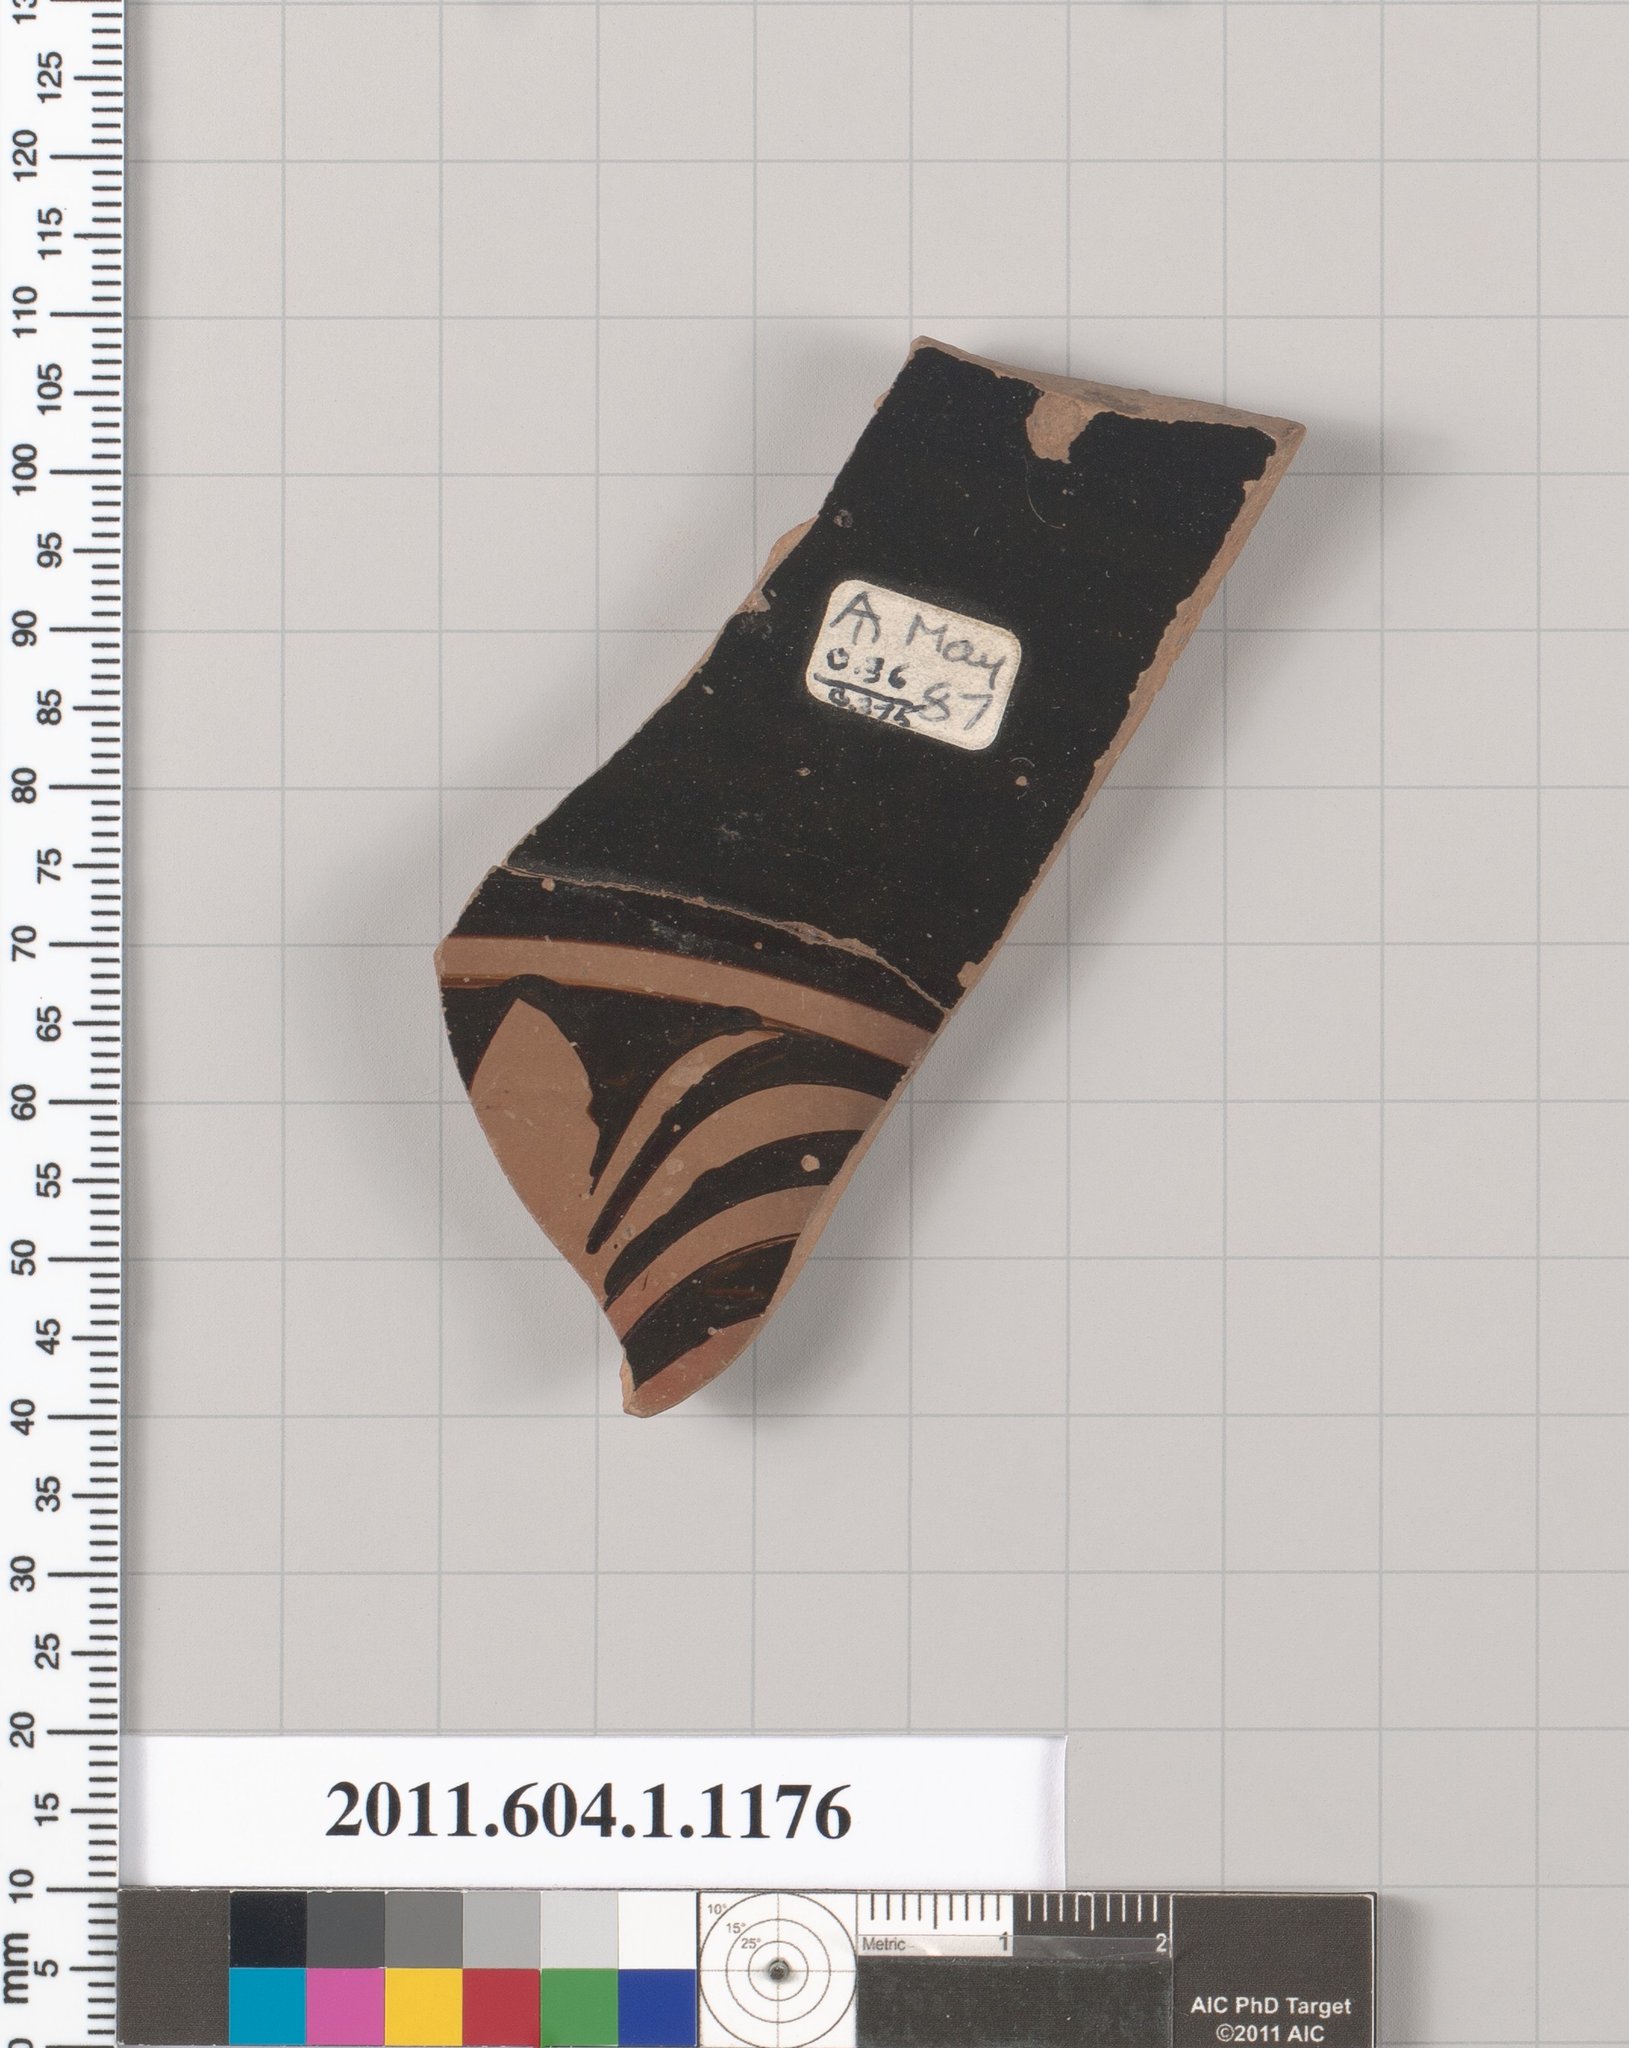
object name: kylix fragment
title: Terracotta fragment of a kylix (drinking cup)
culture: greek, attic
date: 490-480 BCE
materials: terracotta